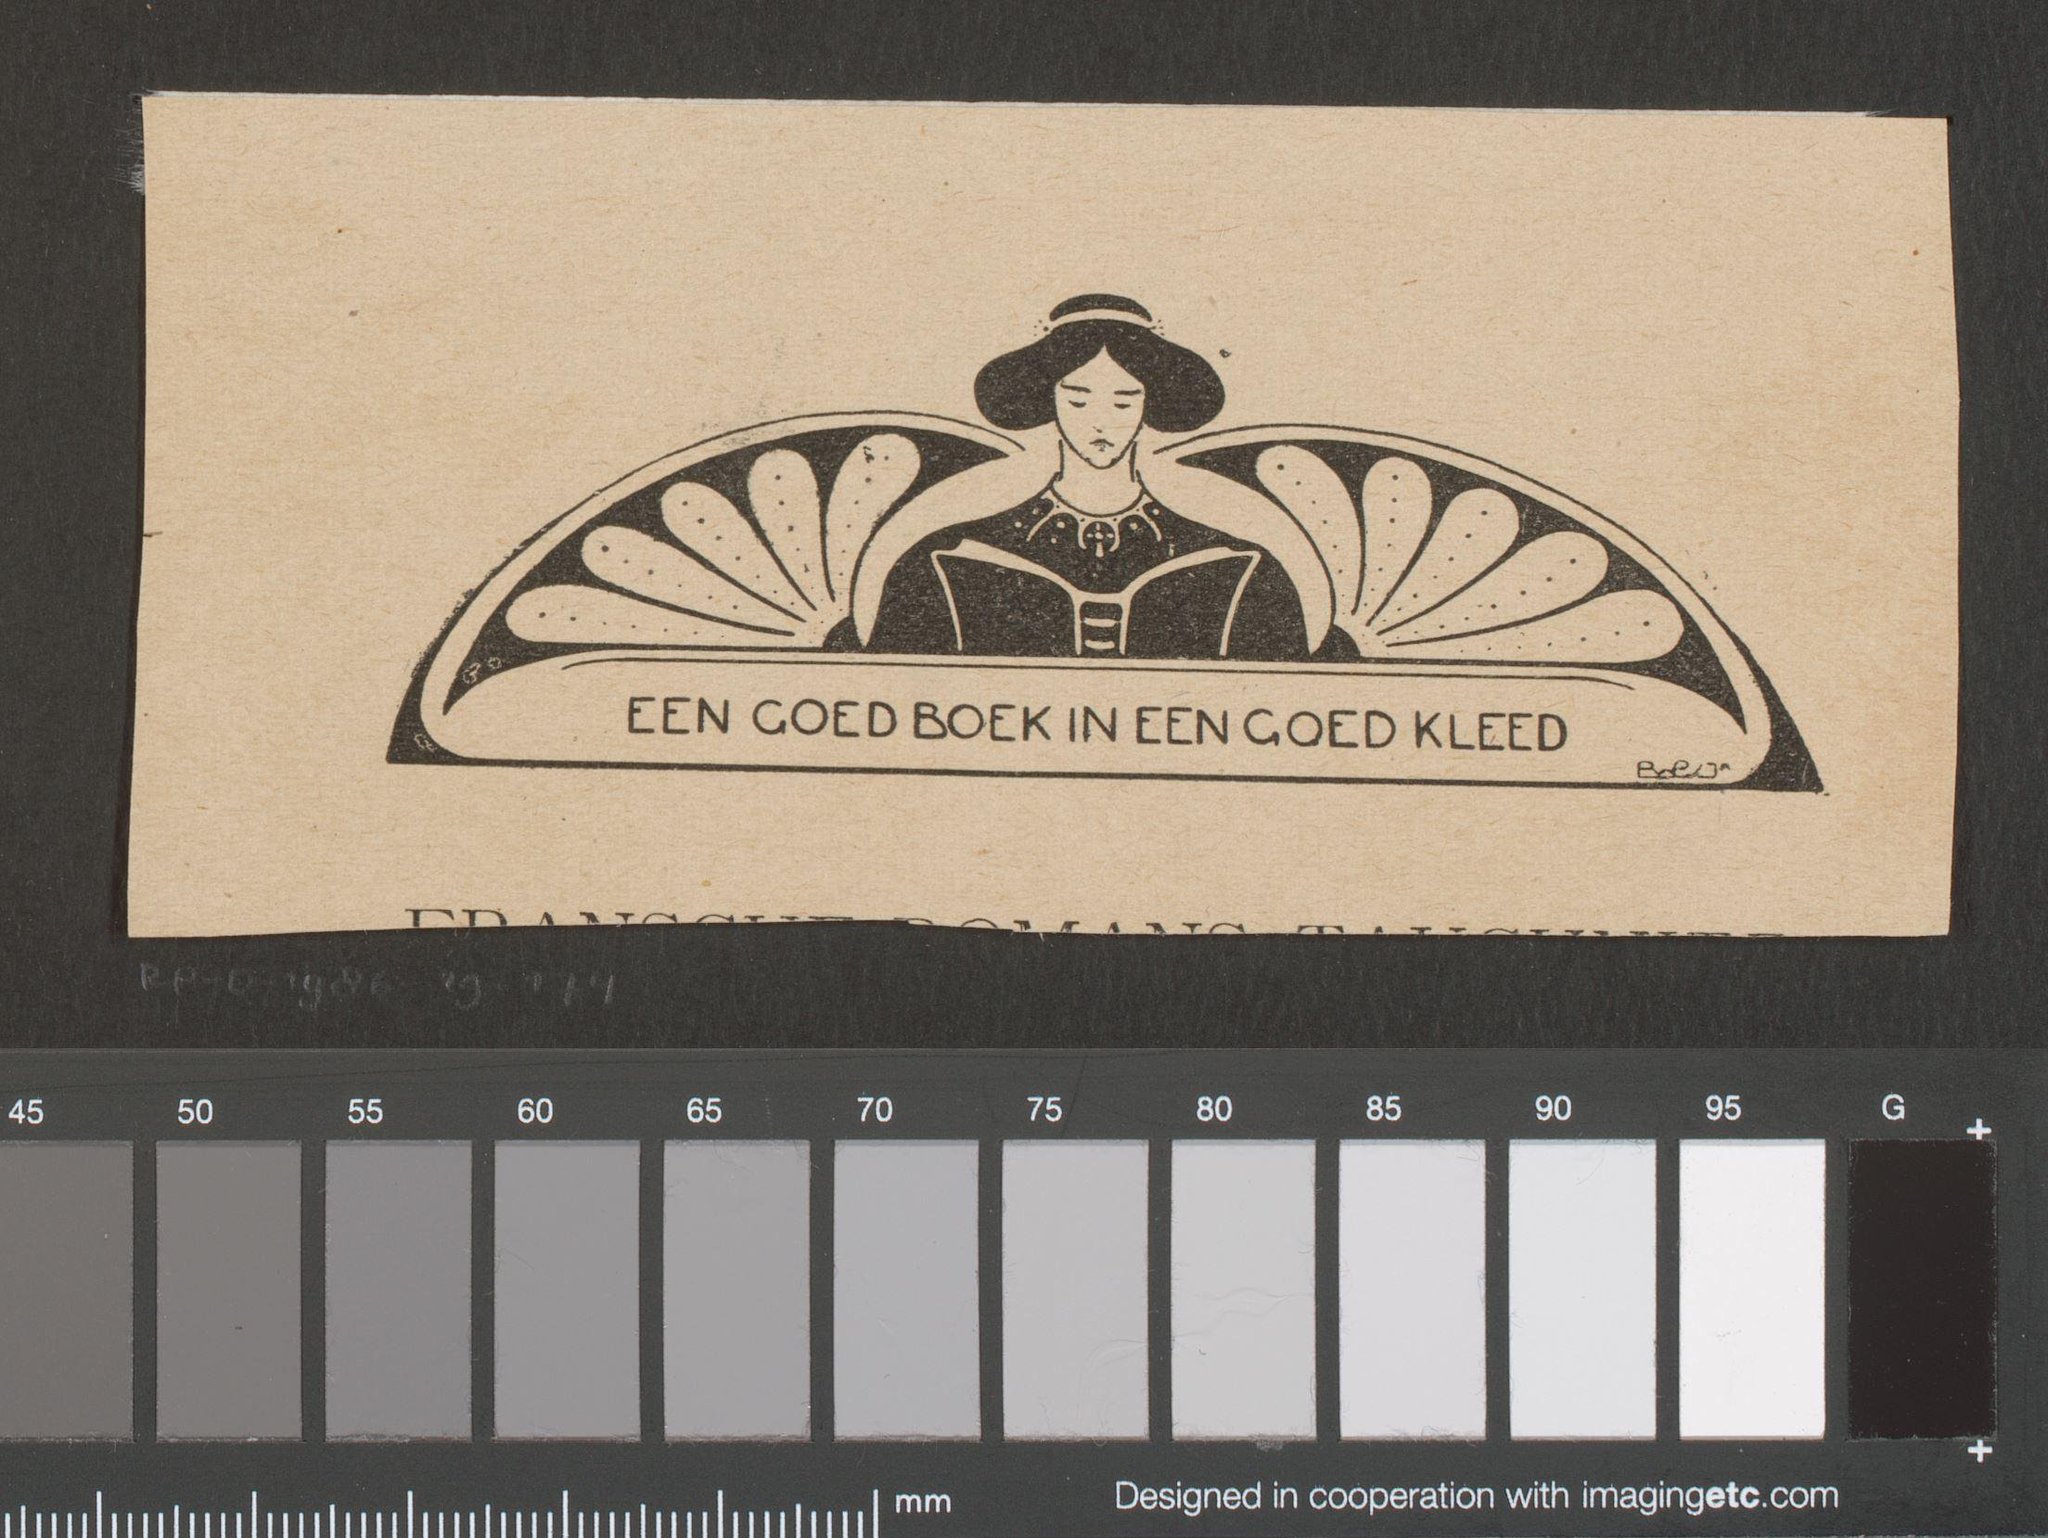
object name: photomechanical print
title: Een goed boek in een goed kleed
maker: reinier willem petrus de vries (1874-1953)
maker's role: draughtsman, print maker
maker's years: 1874-1953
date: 1884-1952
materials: paper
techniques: printing block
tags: reading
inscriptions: collector's mark: ‘R:MVS.’